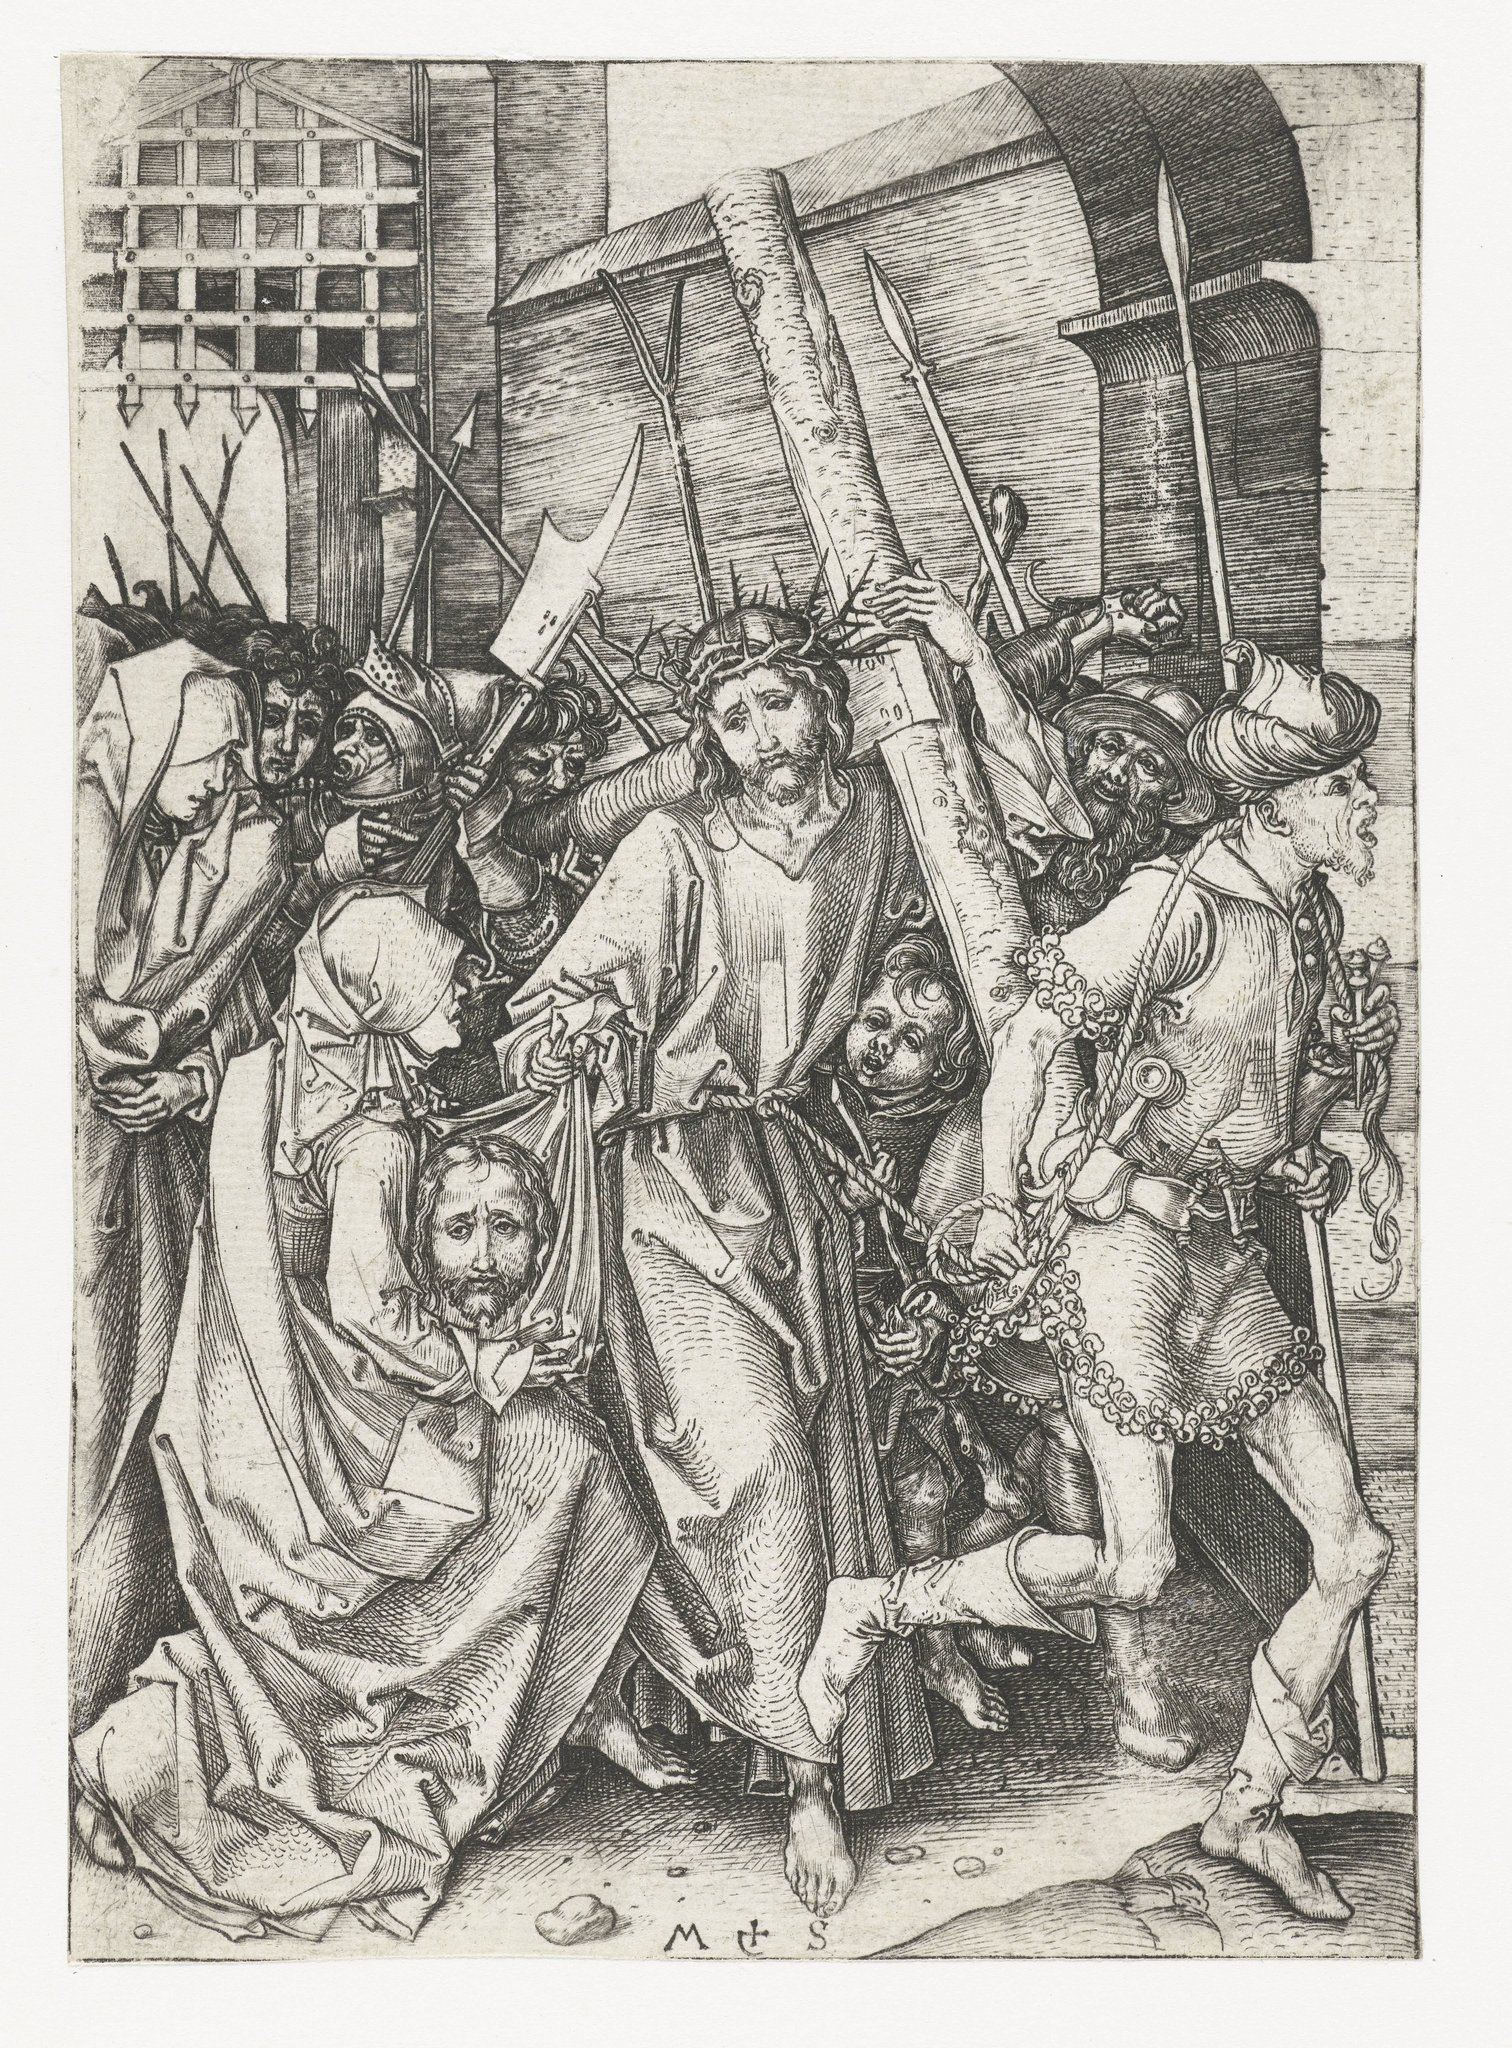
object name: print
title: De Passie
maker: martin schongauer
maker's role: print maker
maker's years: 1430-1491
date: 1470-1491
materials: paper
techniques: engraving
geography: germany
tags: christ meets veronica, who has a cloth to wipe christ's face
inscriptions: collector's mark: Lugt 240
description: Christus loopt met het kruis op de schouder door een stadspoort, omgeven door soldaten met speren. Naast hem knielt een vrouw met een doek (Veronica). Deze prent is onderdeel van een serie van twaalf prenten met scènes uit het Lijdensverhaal.